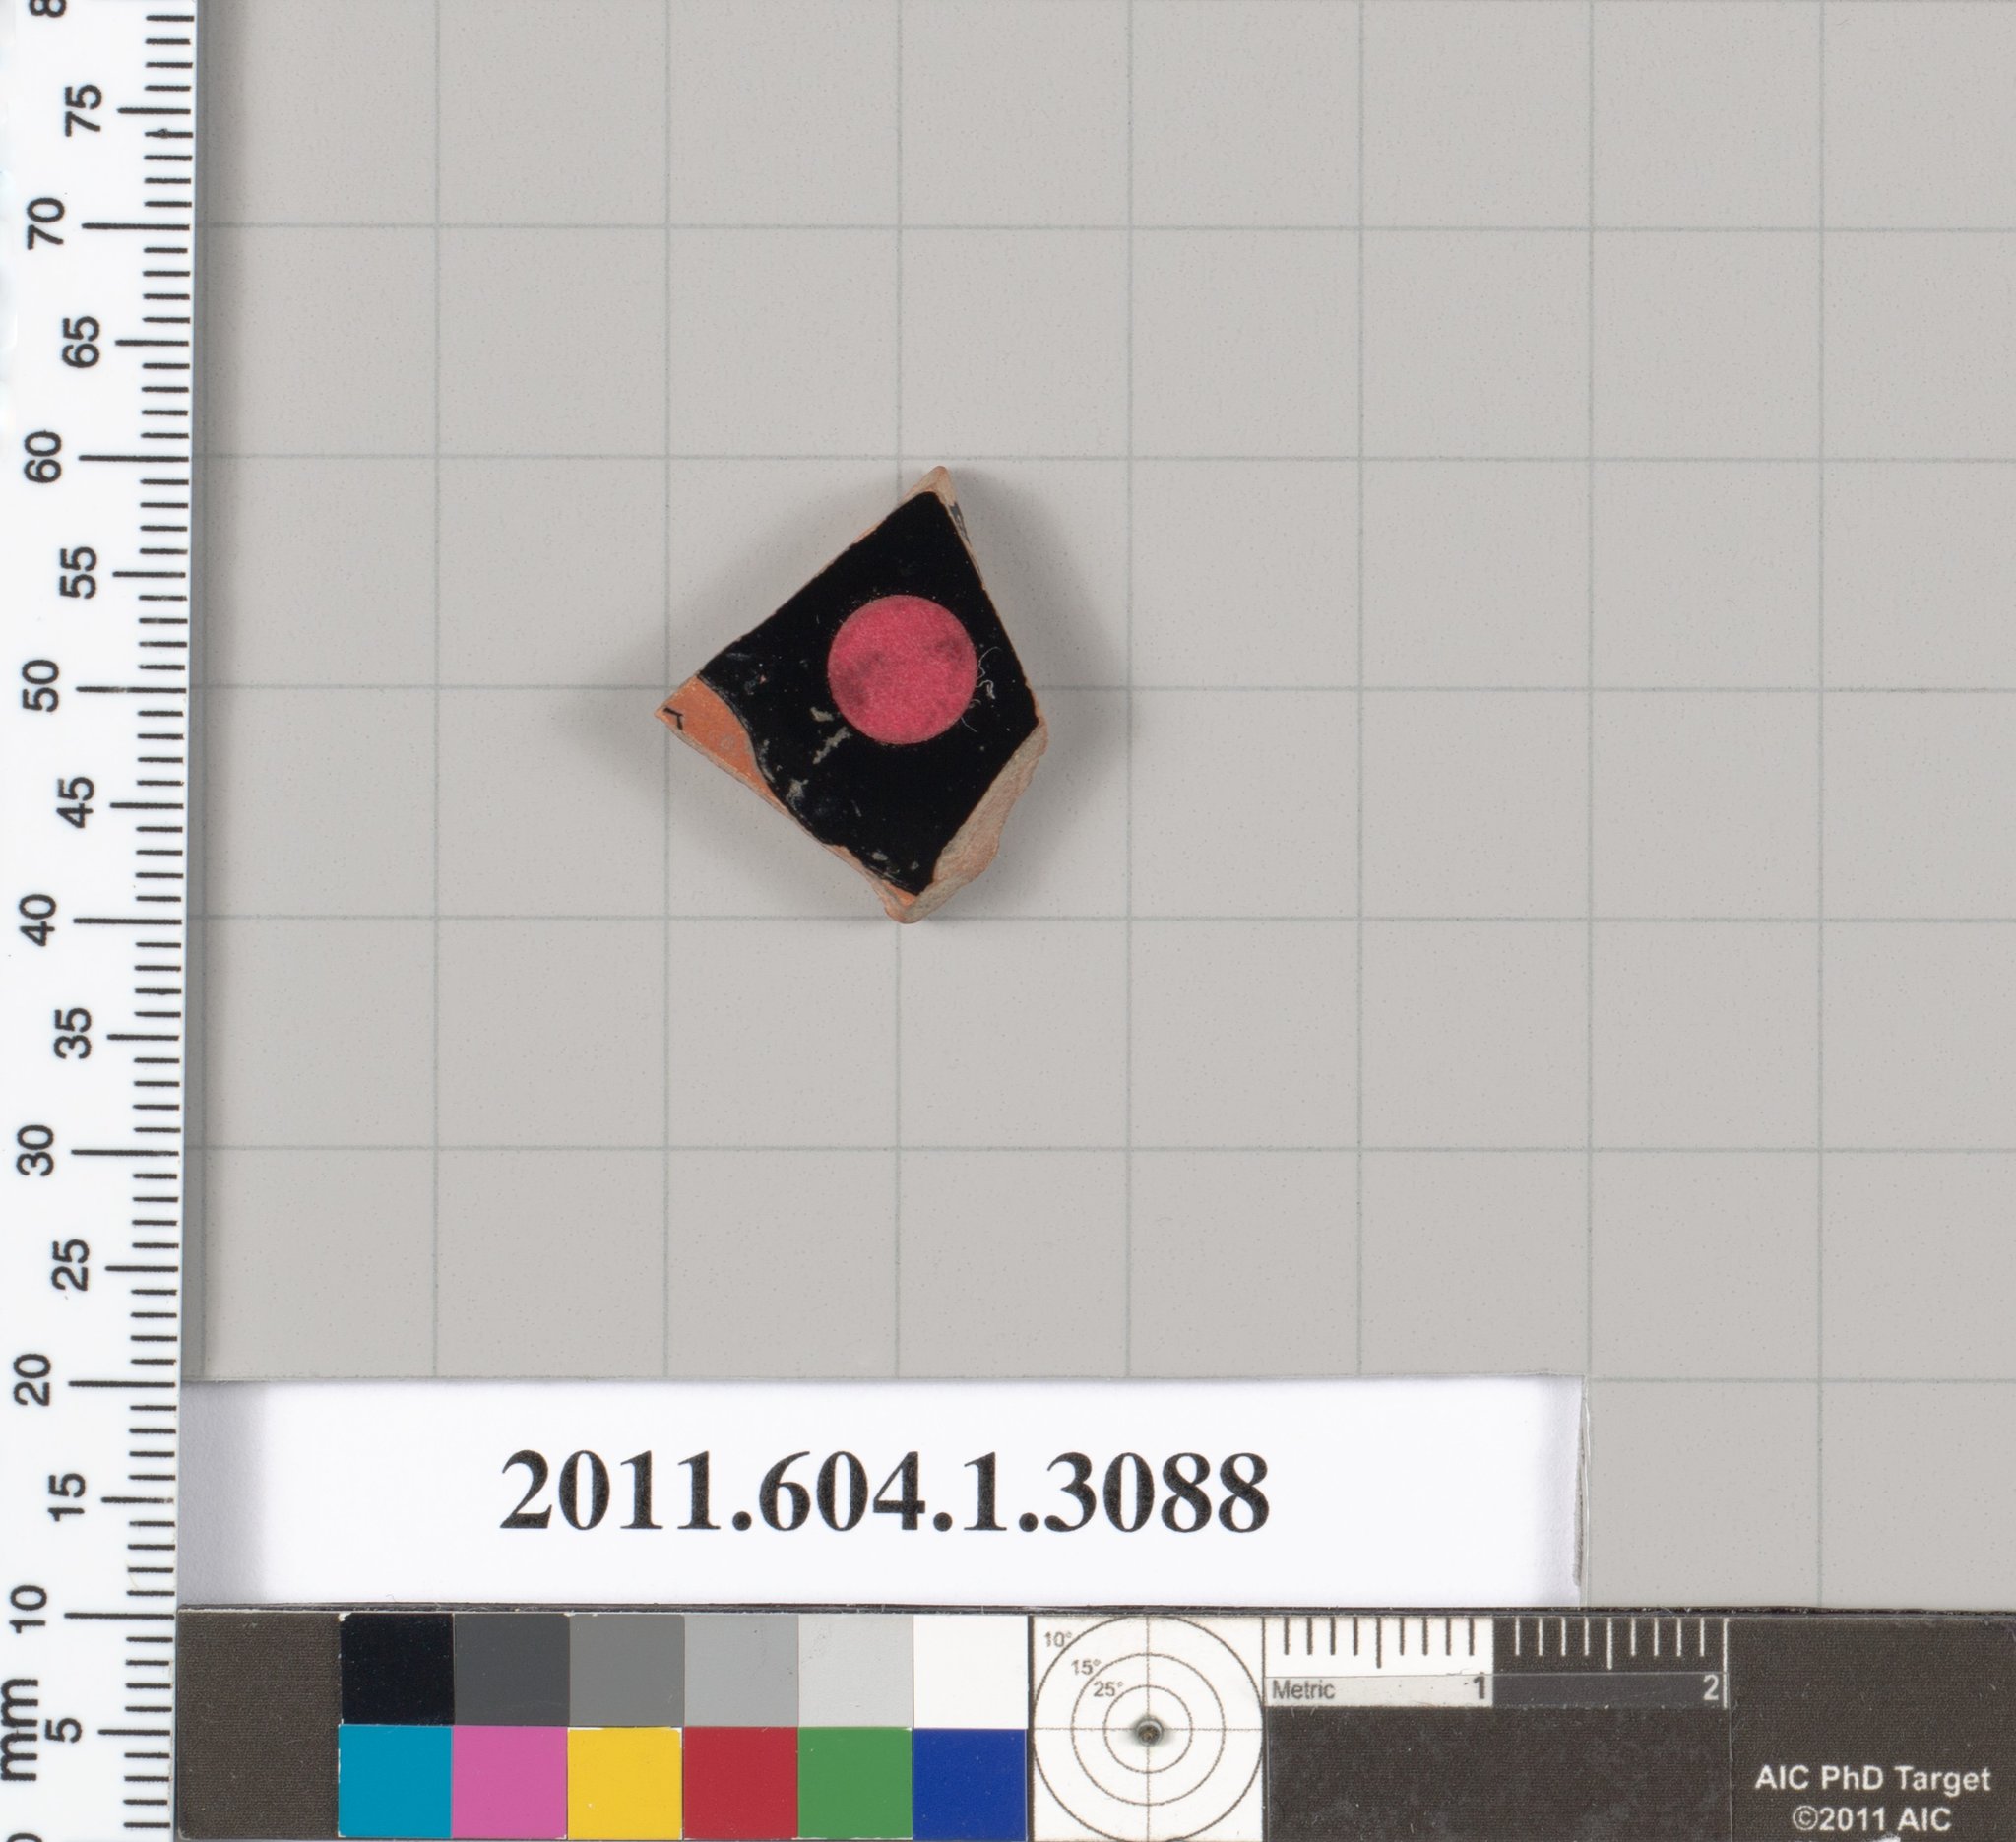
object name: kylix fragment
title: Terracotta fragment of a kylix (drinking cup)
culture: greek, attic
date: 500-451 BCE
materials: terracotta